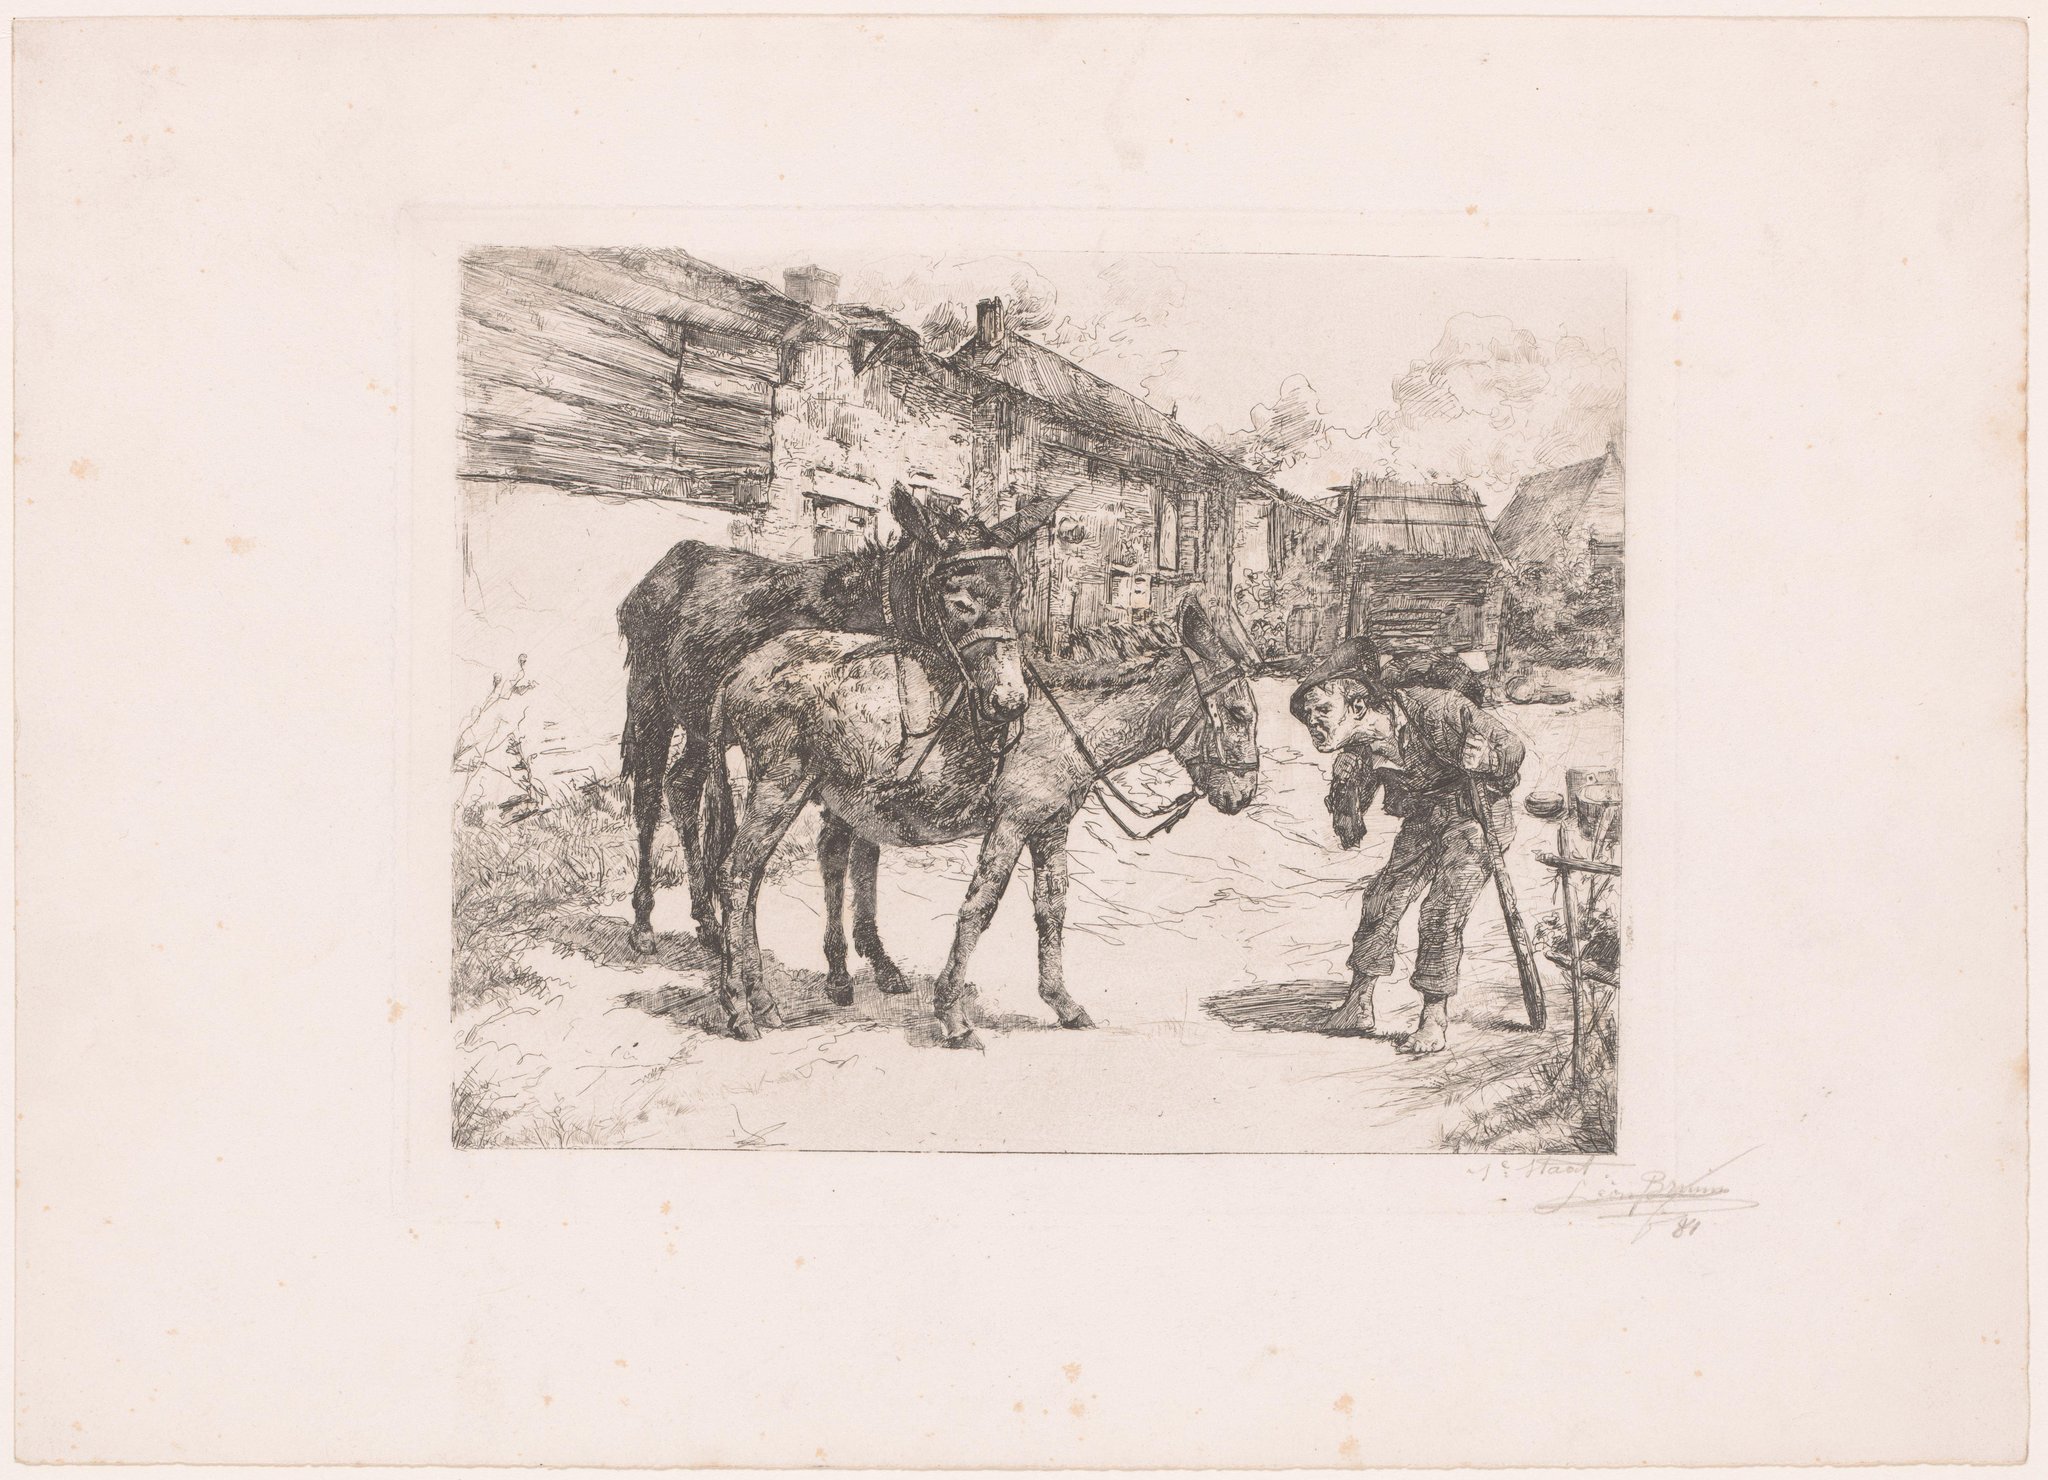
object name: print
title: Man schreeuwt tegen twee ezels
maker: léon brunin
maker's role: print maker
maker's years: 1861-1949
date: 1884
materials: paper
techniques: etching, intaglio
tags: ass, donkey, rage, anger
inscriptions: annotation: ‘1e staat’, collector's mark: Lugt 2228